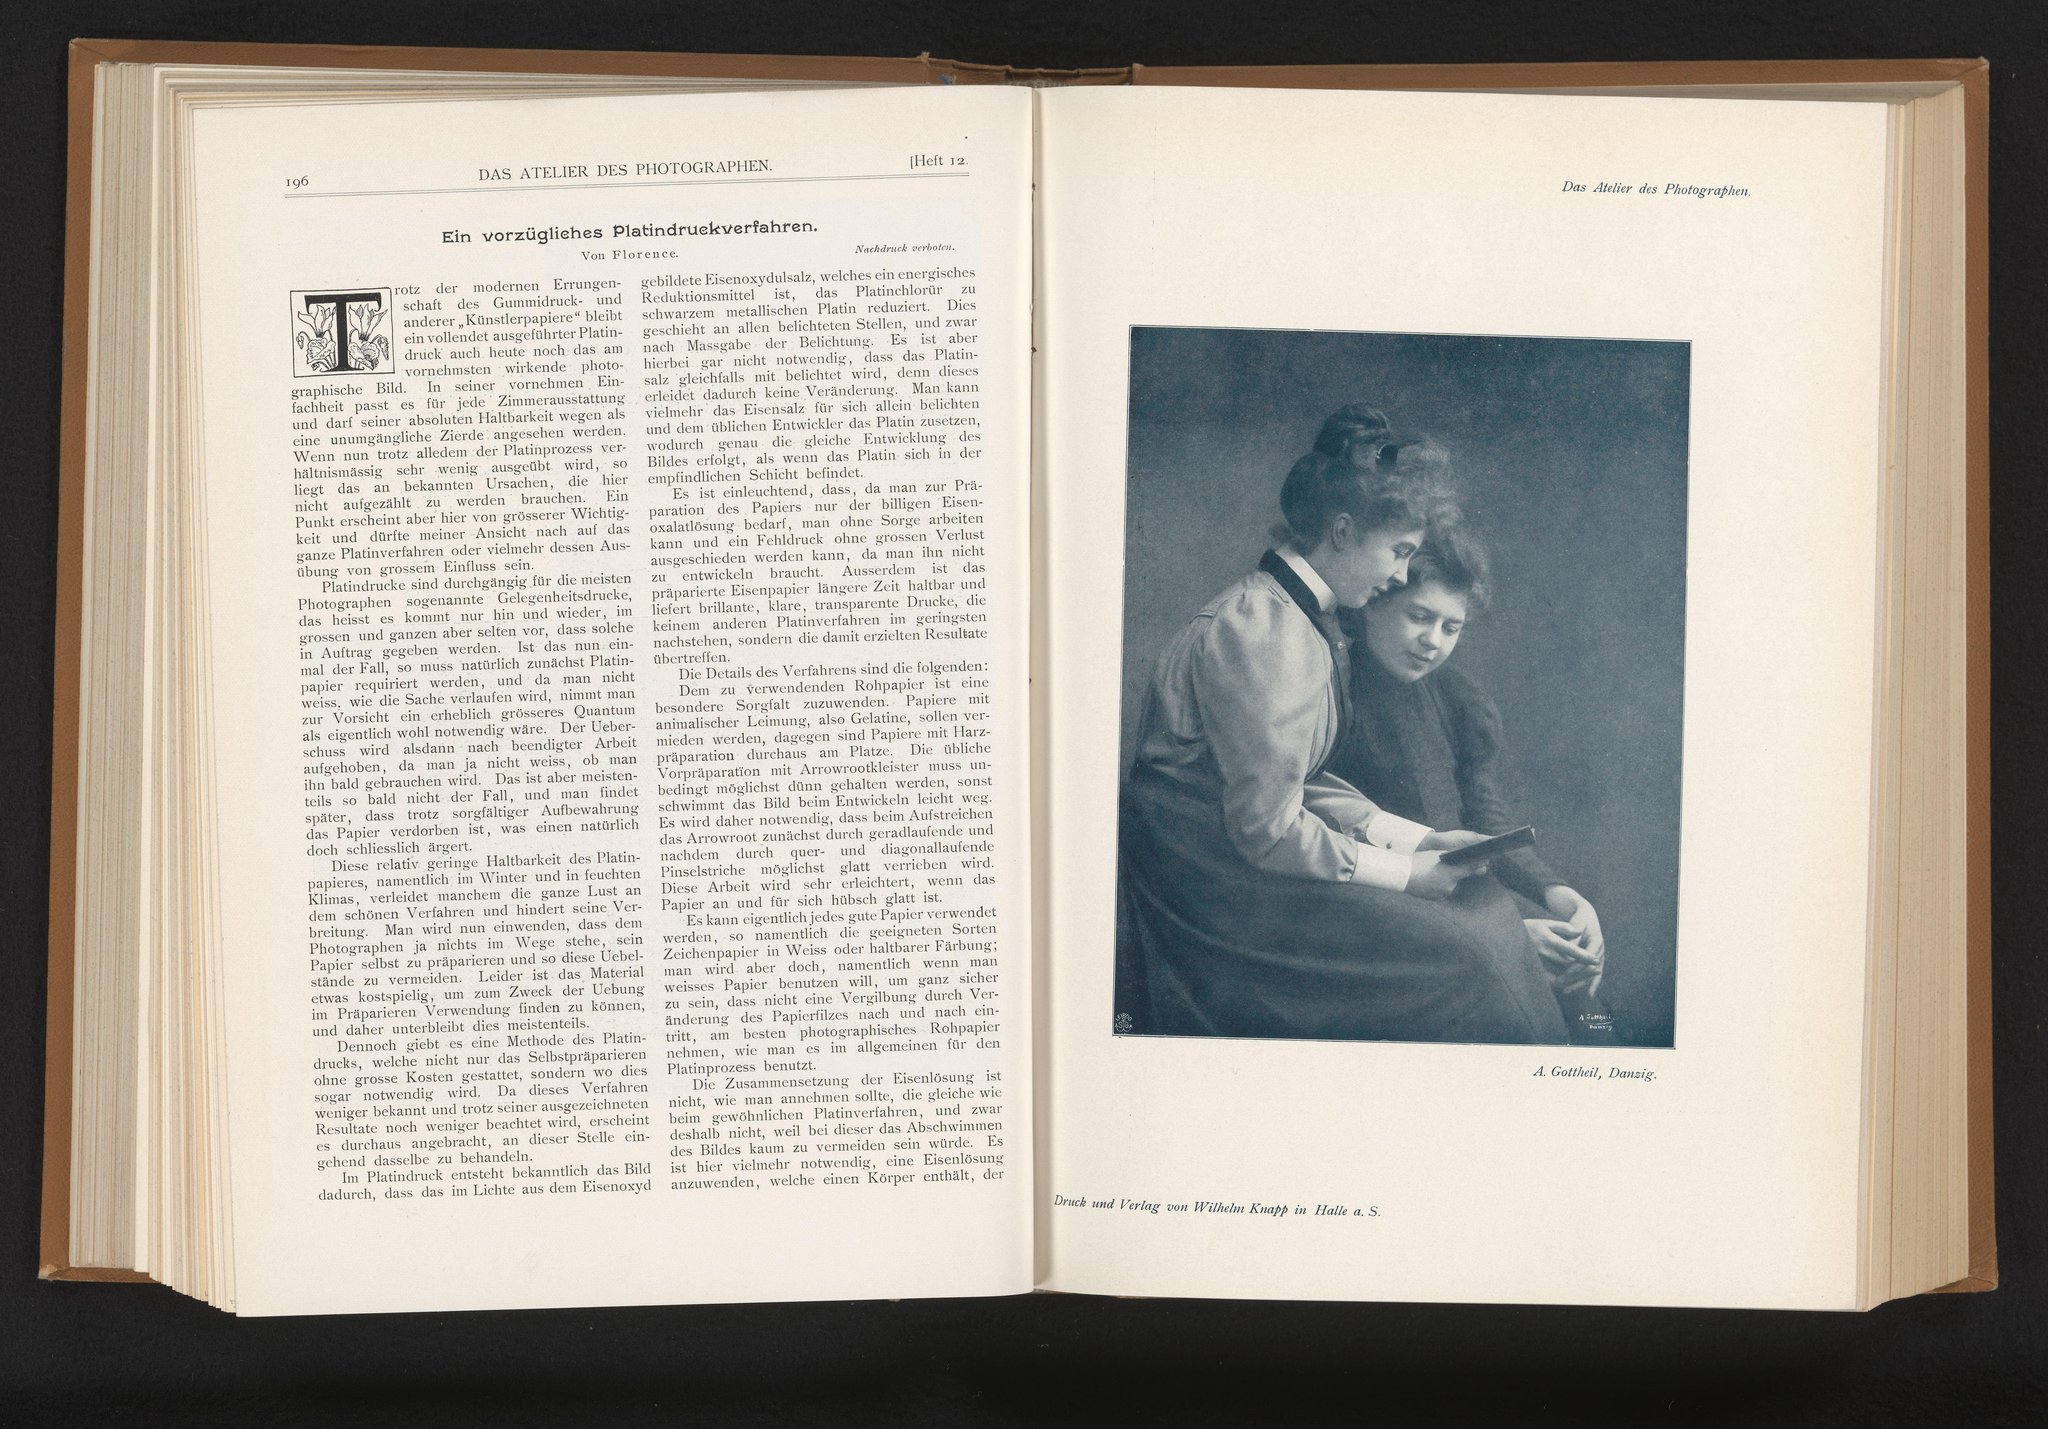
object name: page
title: Twee vrouwen lezen een kaart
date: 1895-1900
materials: paper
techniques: autotype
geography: halle an der saale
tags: reading, adult woman (+ two persons)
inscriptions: monogram: ‘LEIPZIG/ S G’, inscription: ‘Das Atelier des Photographen.’